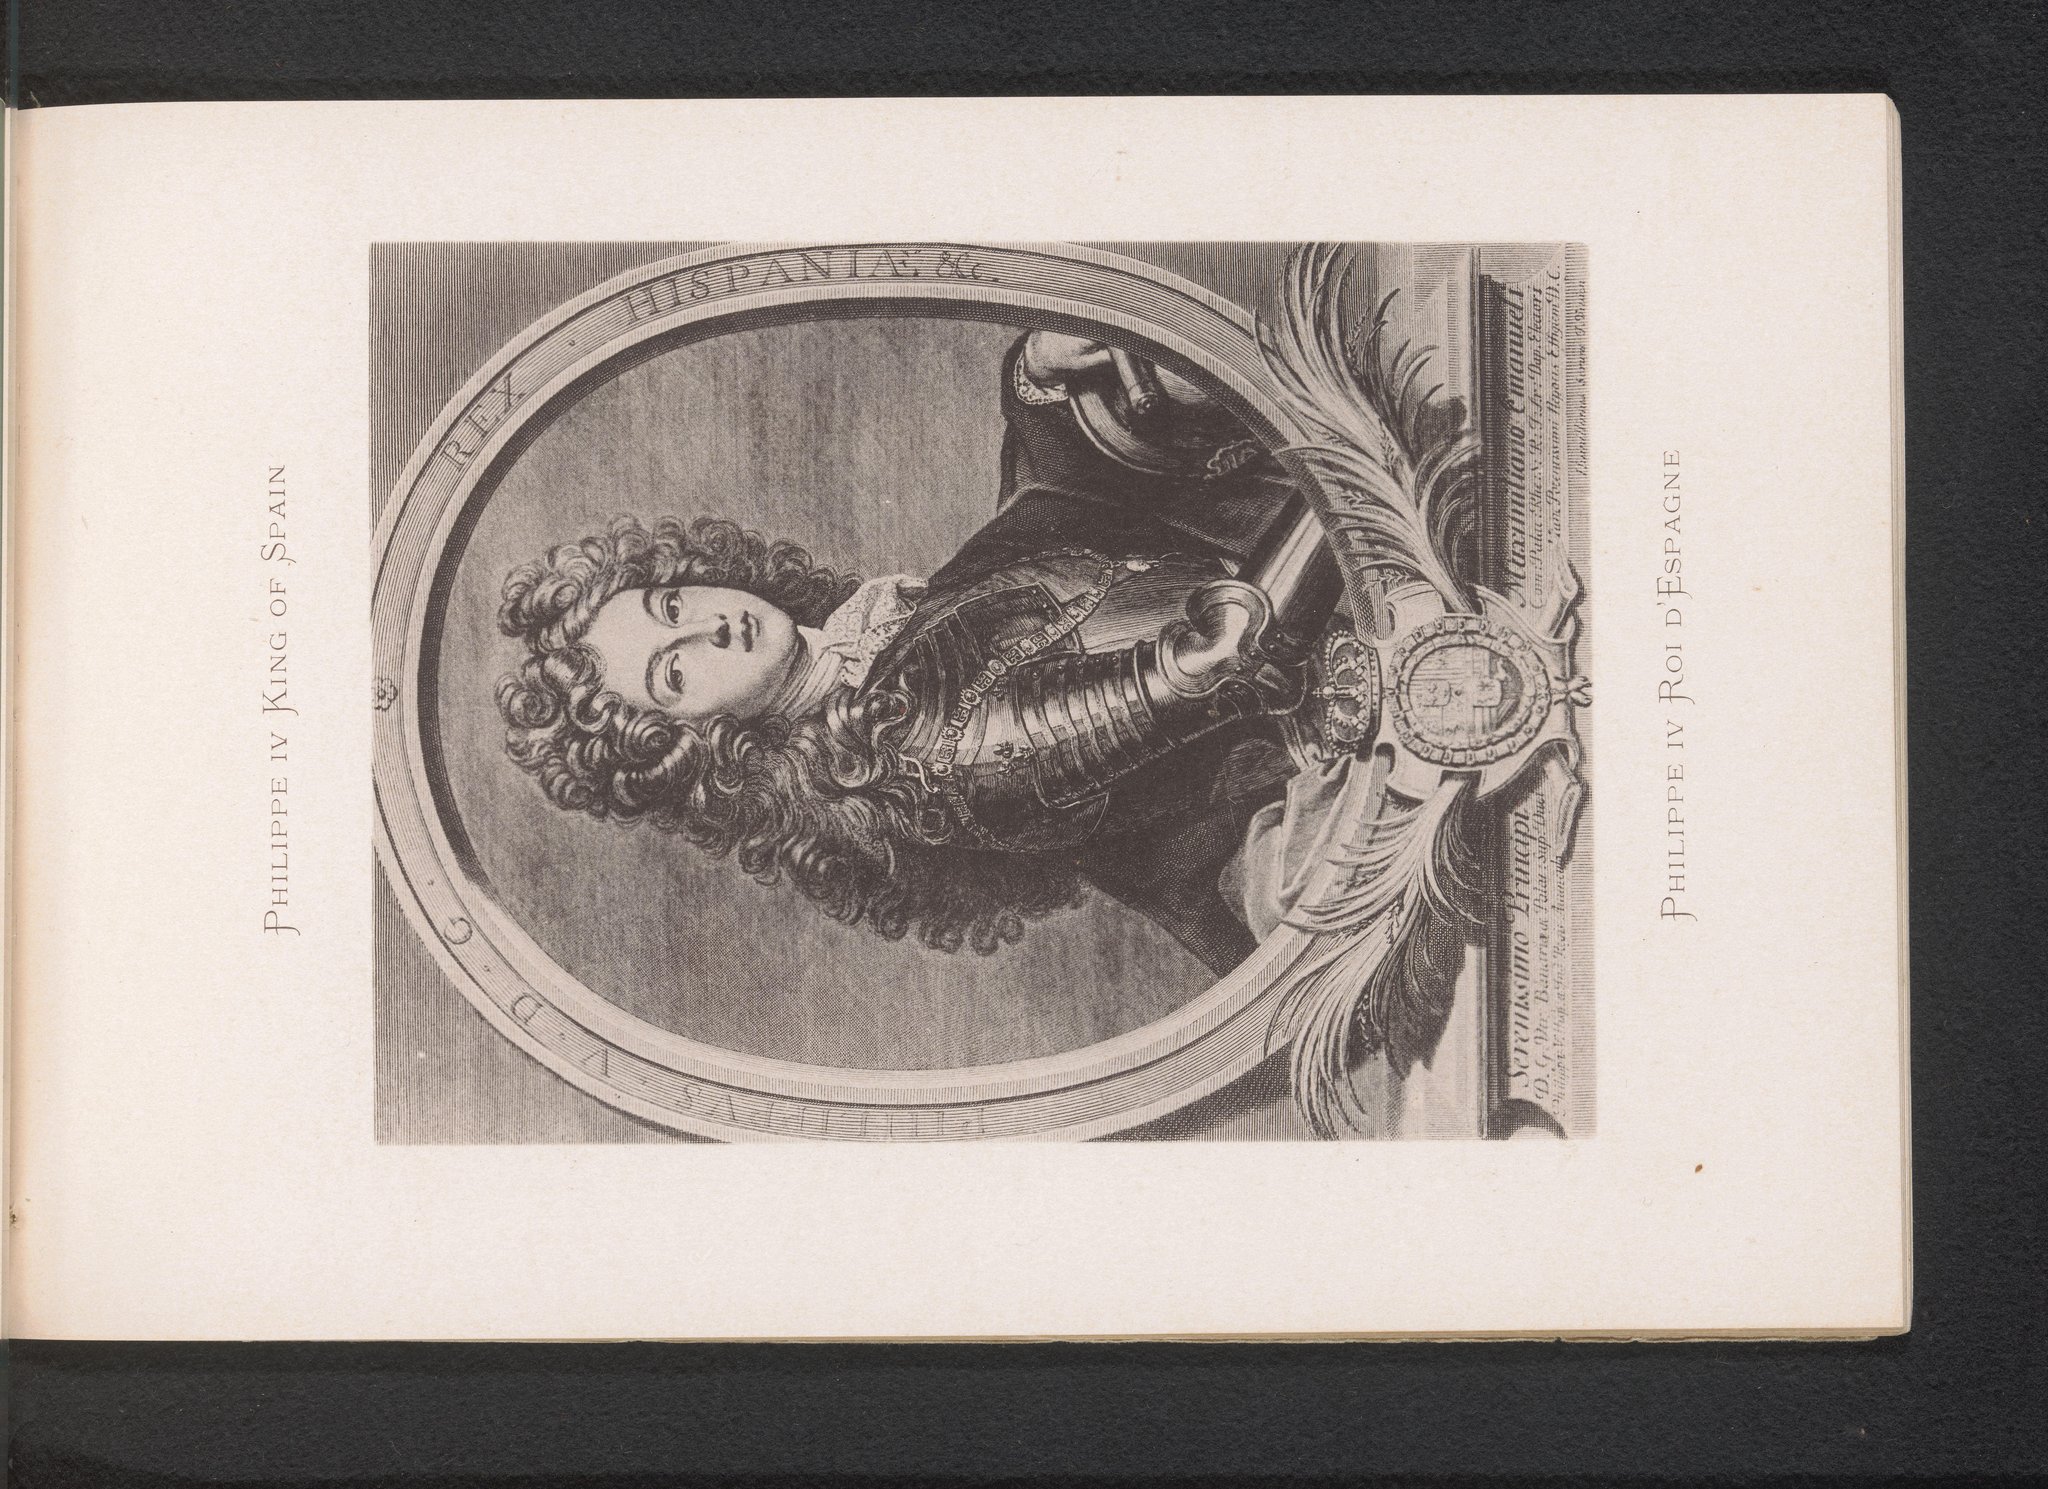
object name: reproduction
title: Phelippe IV Roi d'Espagne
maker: Anonymous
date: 1892-1897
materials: paper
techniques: photograph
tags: filips iv (koning van spanje), youth, adolescent, king